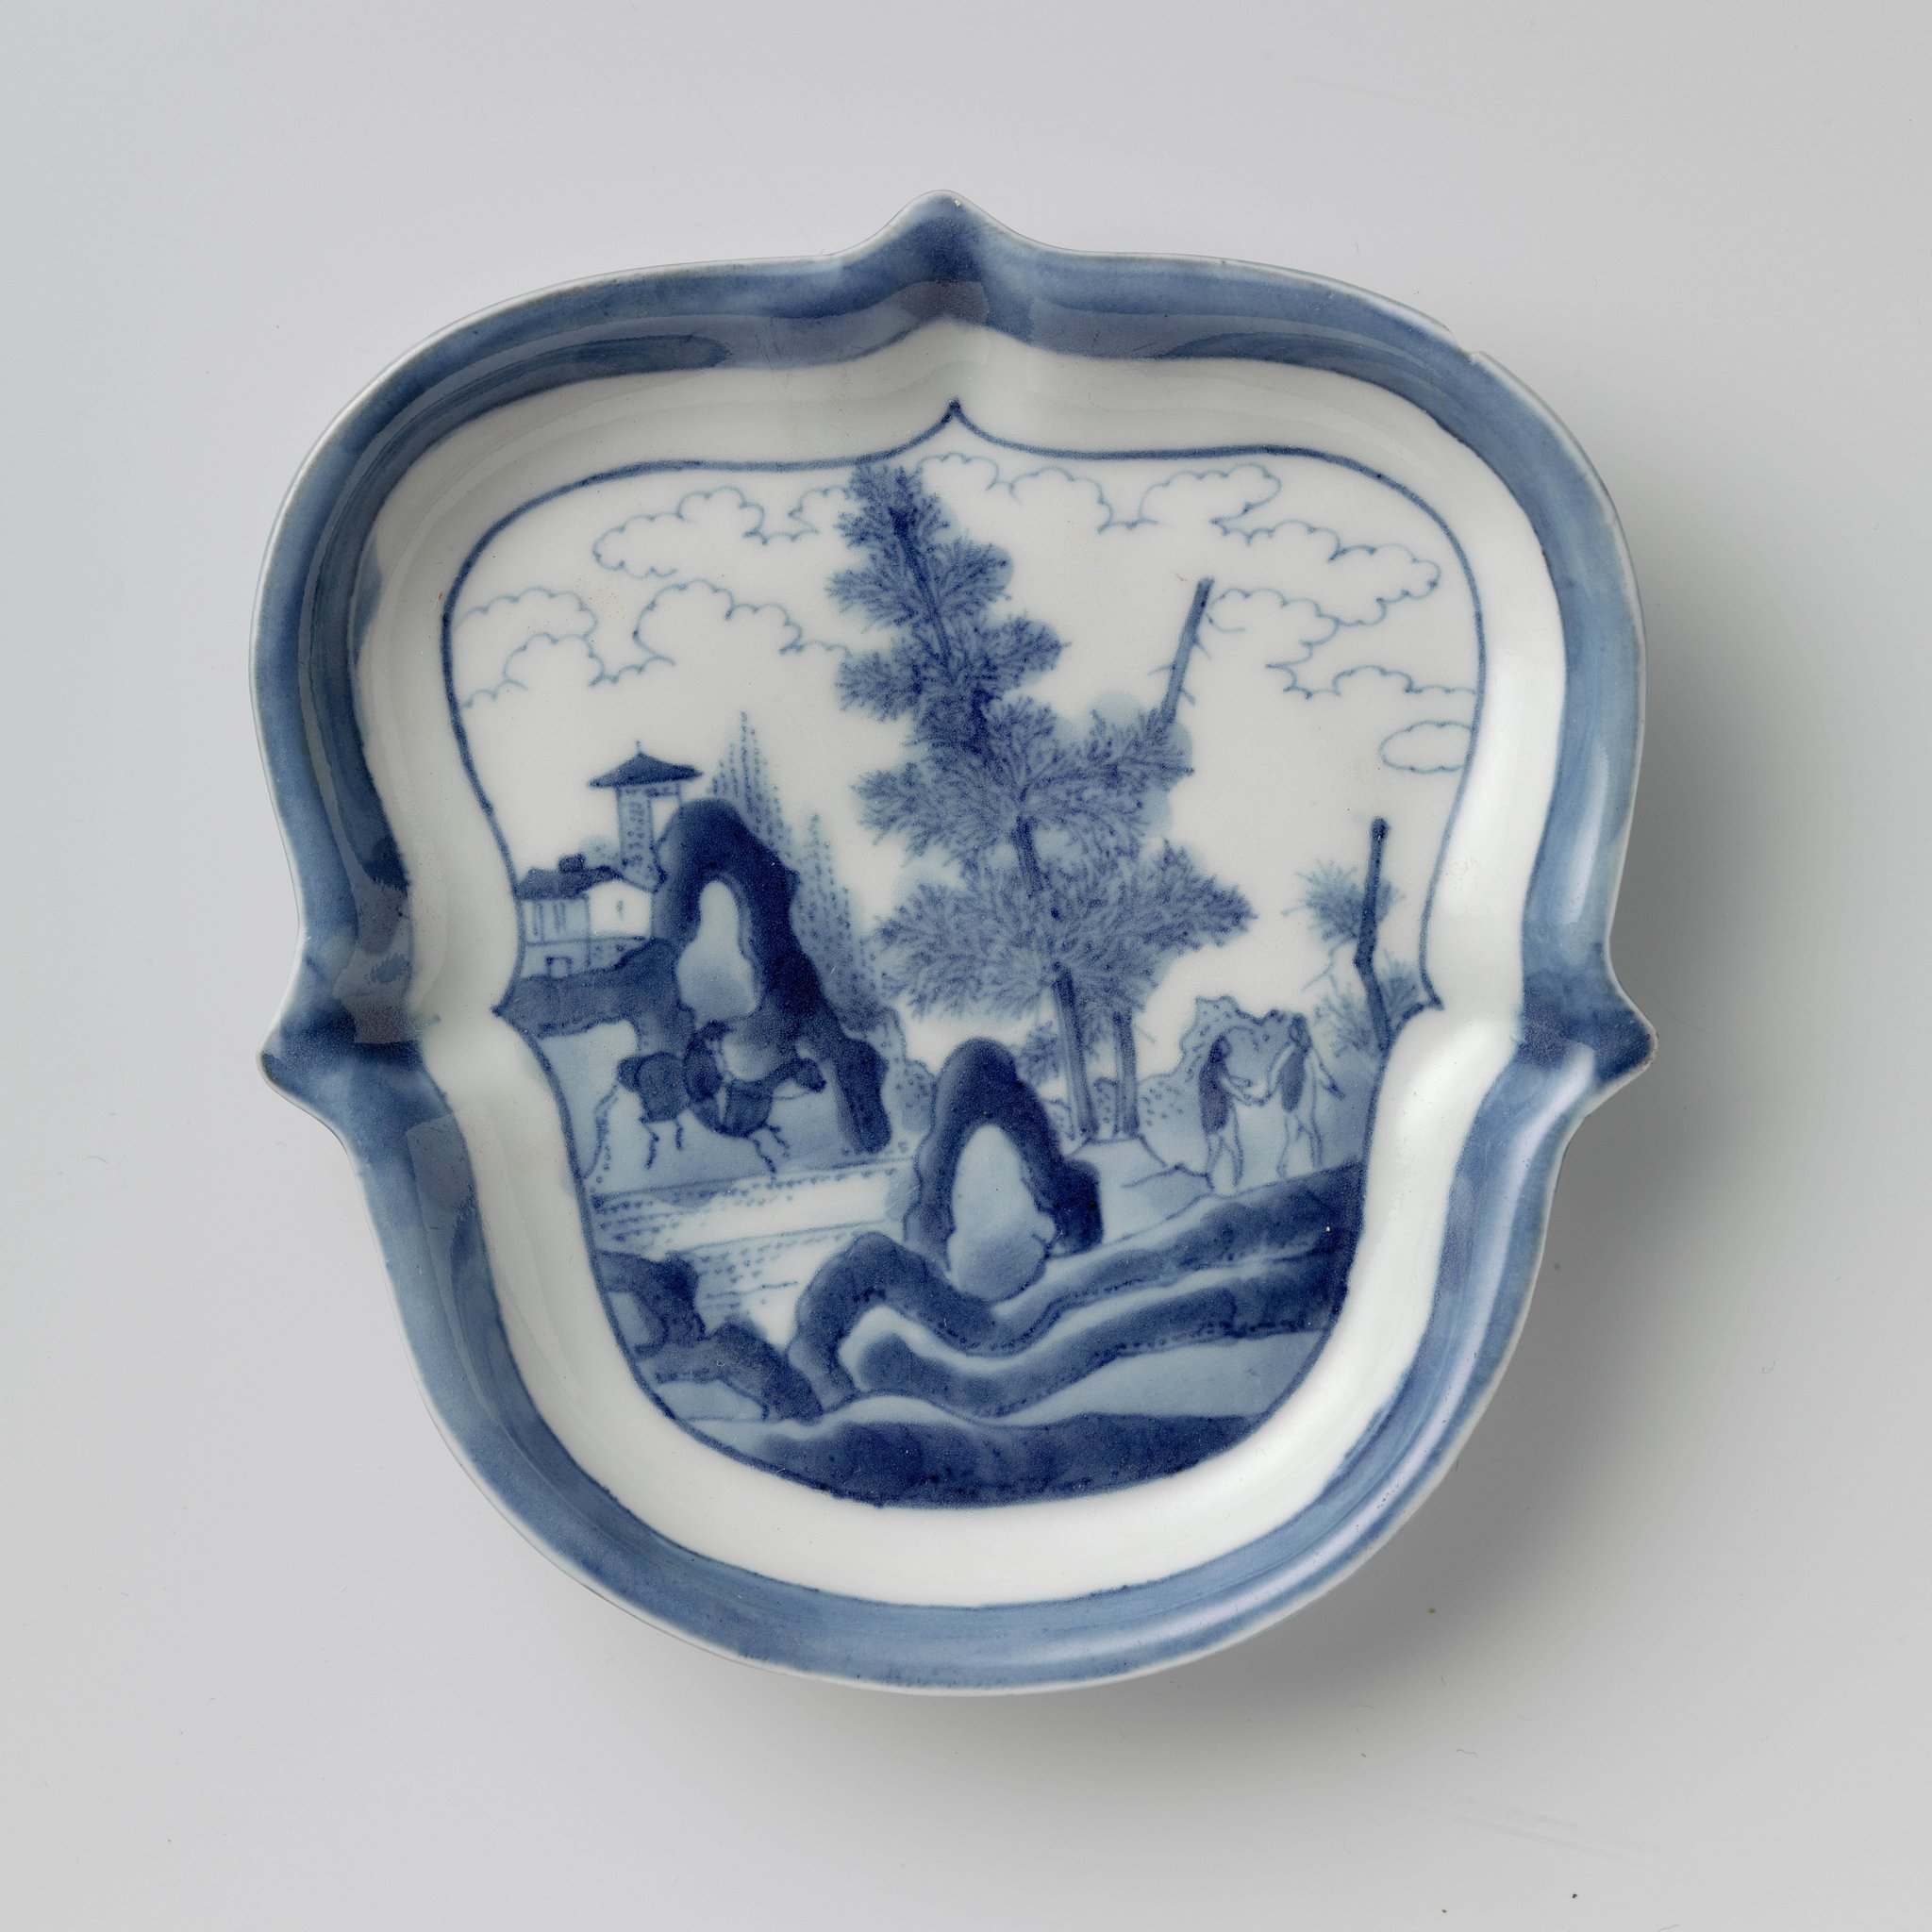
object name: dish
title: Saucer with figures in a landscape with trees, rocks and pavilions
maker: Anonymous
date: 1700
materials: cobalt, glaze, paint, porcelain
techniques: firing, forming, vitrification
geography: japan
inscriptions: mark: ‘大 明 成 化 年 製 dà míng Chénghuà nián zhì’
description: Landscapes with European-looking figures and buildings appear in many variations on Japanese export porcelain meant for the European market. They were probably based on Dutch prints, or Delftware, which may explain why the clouds are depicted in a European manner.